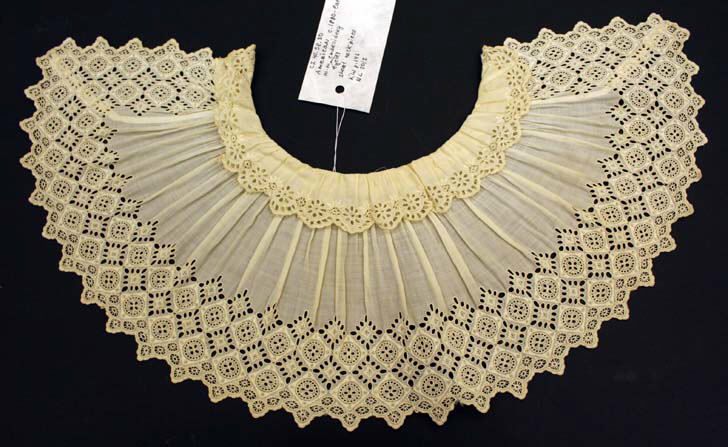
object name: collar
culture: american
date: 1700-1941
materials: cotton